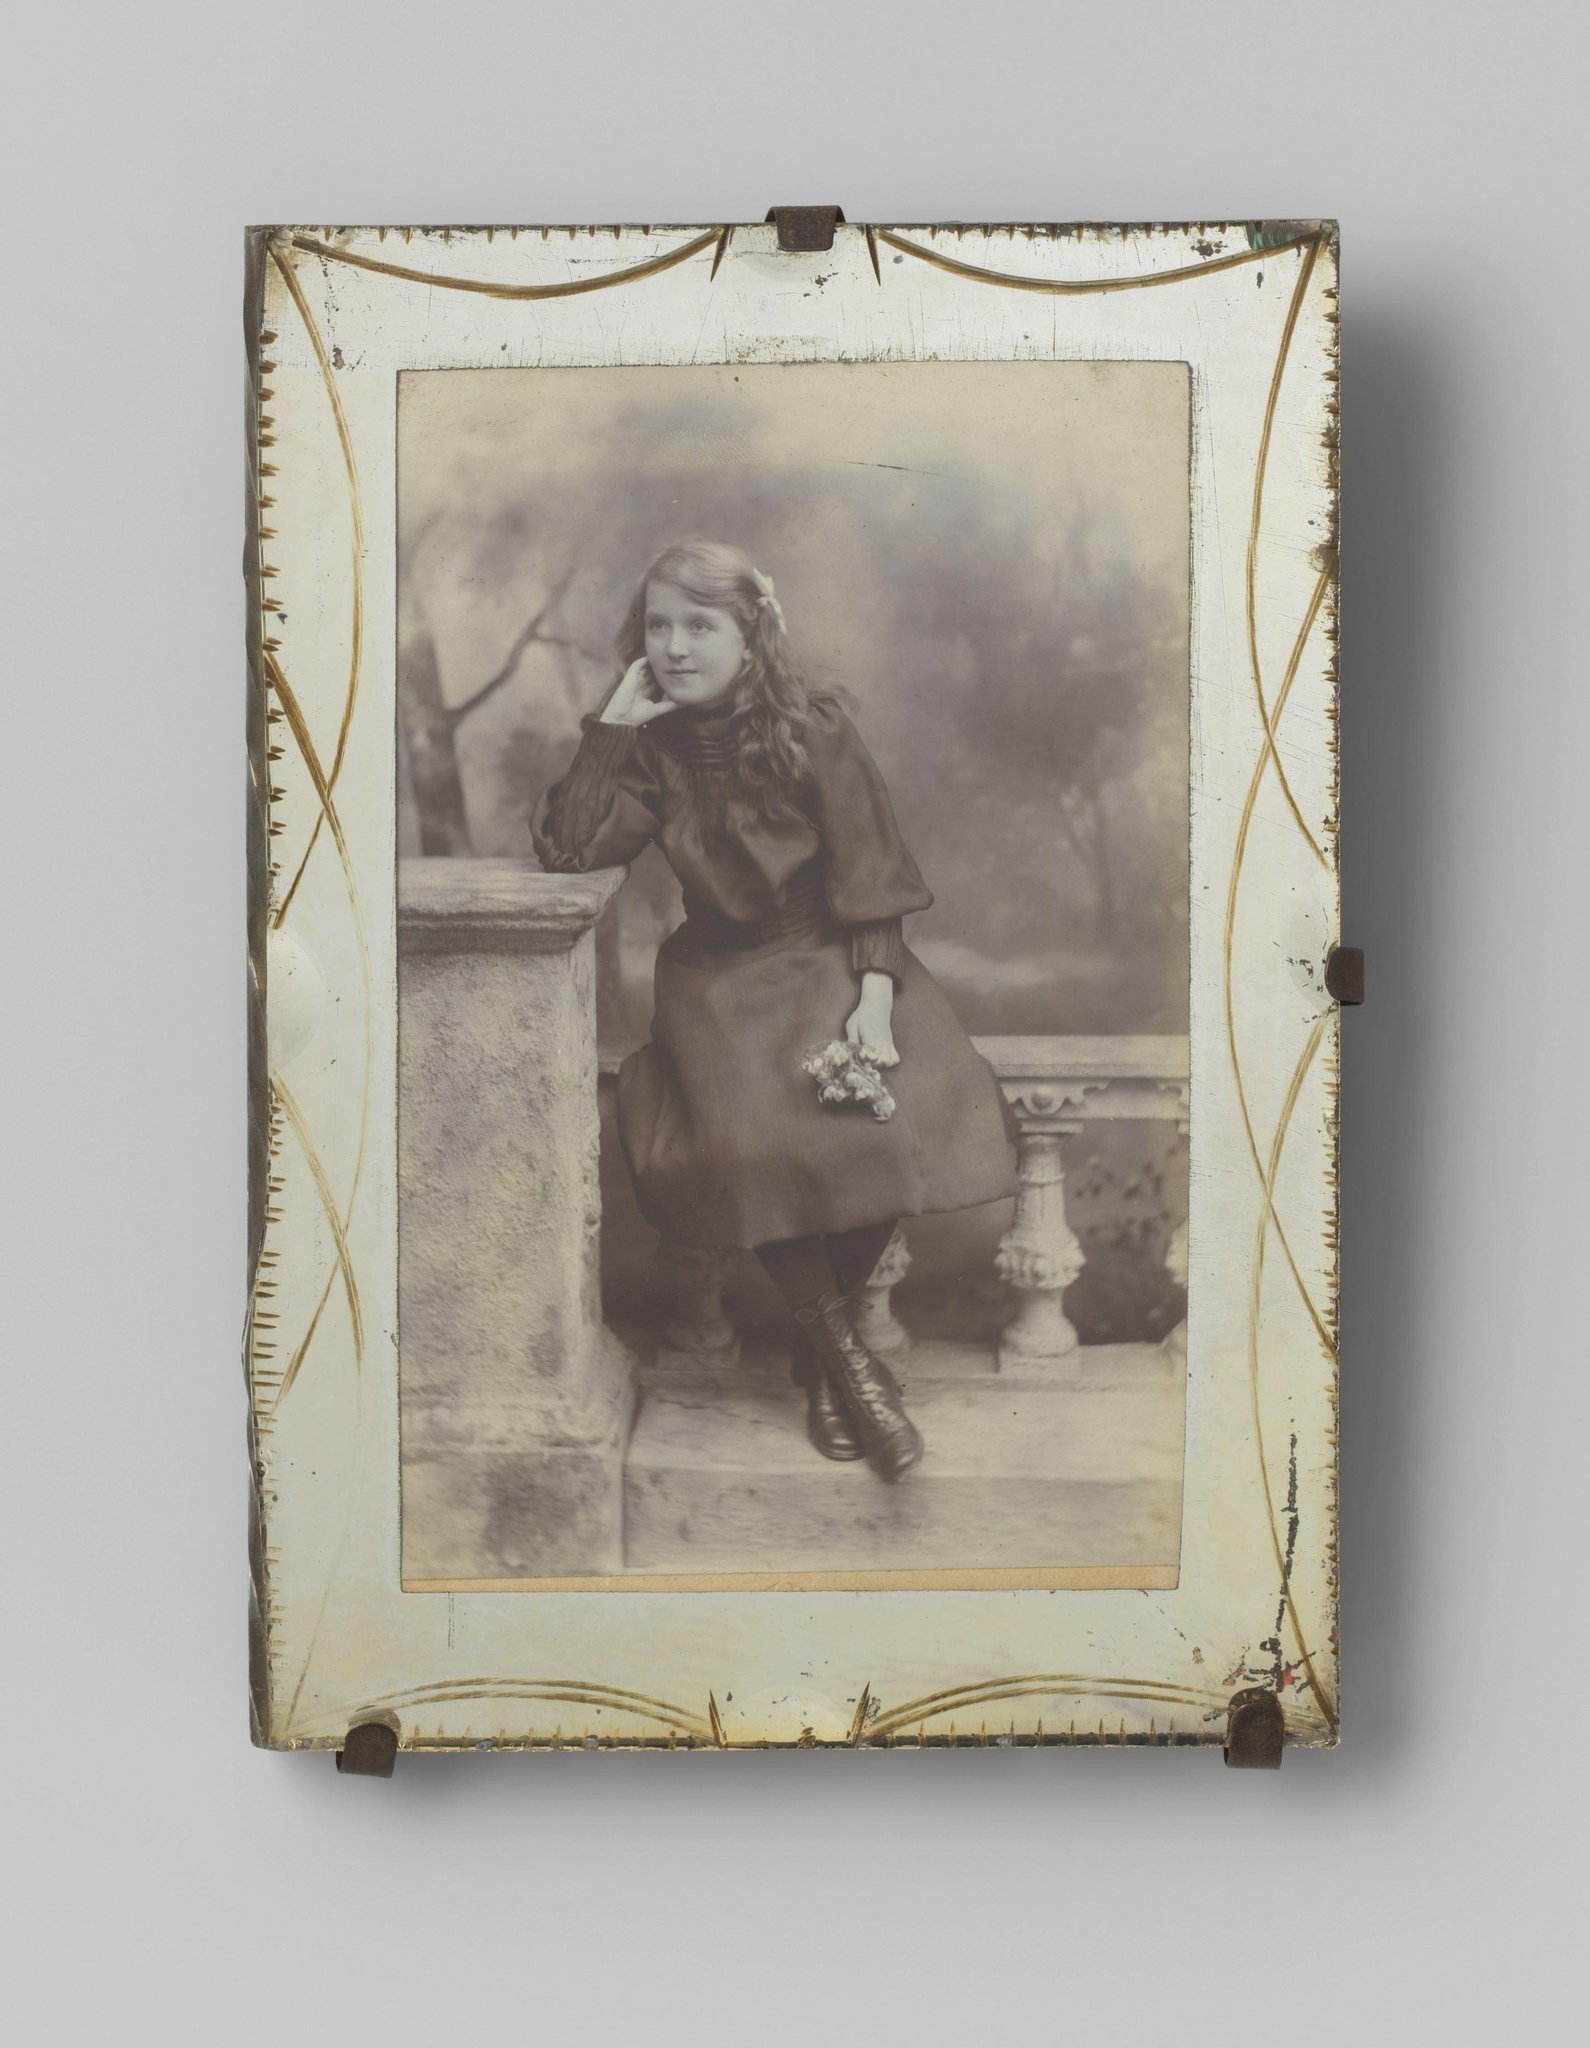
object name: photograph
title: Portret van een onbekend meisje, zittend op een balustrade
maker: Anonymous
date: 1880-1900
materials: paper, cardboard, glass, leather, metal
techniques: grinding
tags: girl (child between toddler and youth), anonymous historical person portrayed